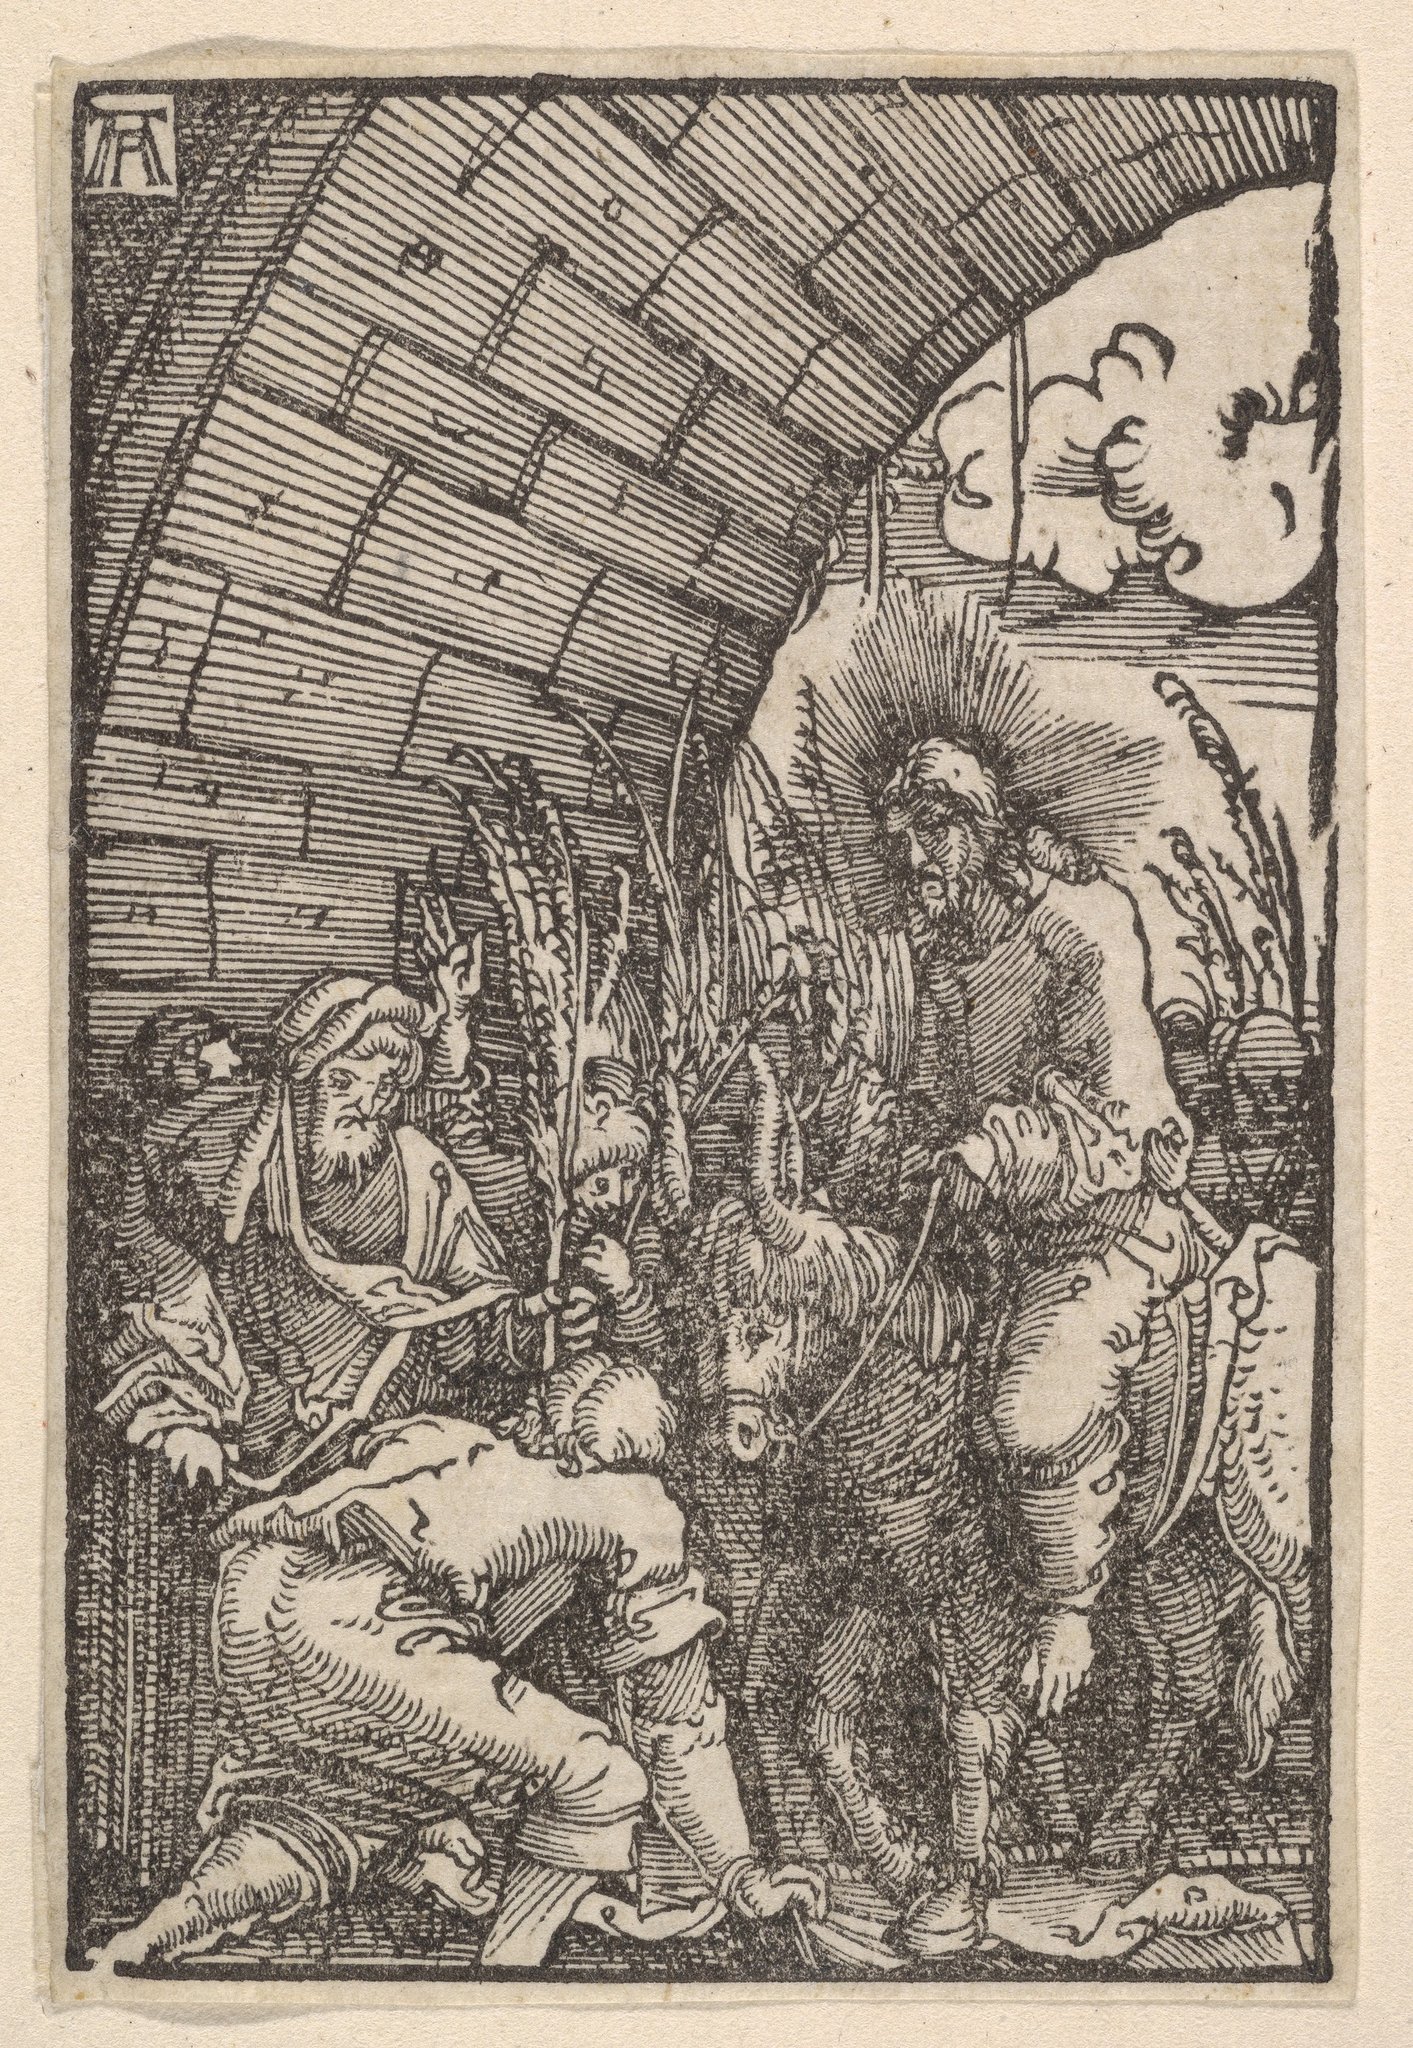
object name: print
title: Entry into Jerusalem, from "The Fall and Salvation of Mankind Through the Life and Passion of Christ"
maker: albrecht altdorfer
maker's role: artist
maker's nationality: german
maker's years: 1480-1538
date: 1513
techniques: woodcut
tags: animals,men,christ